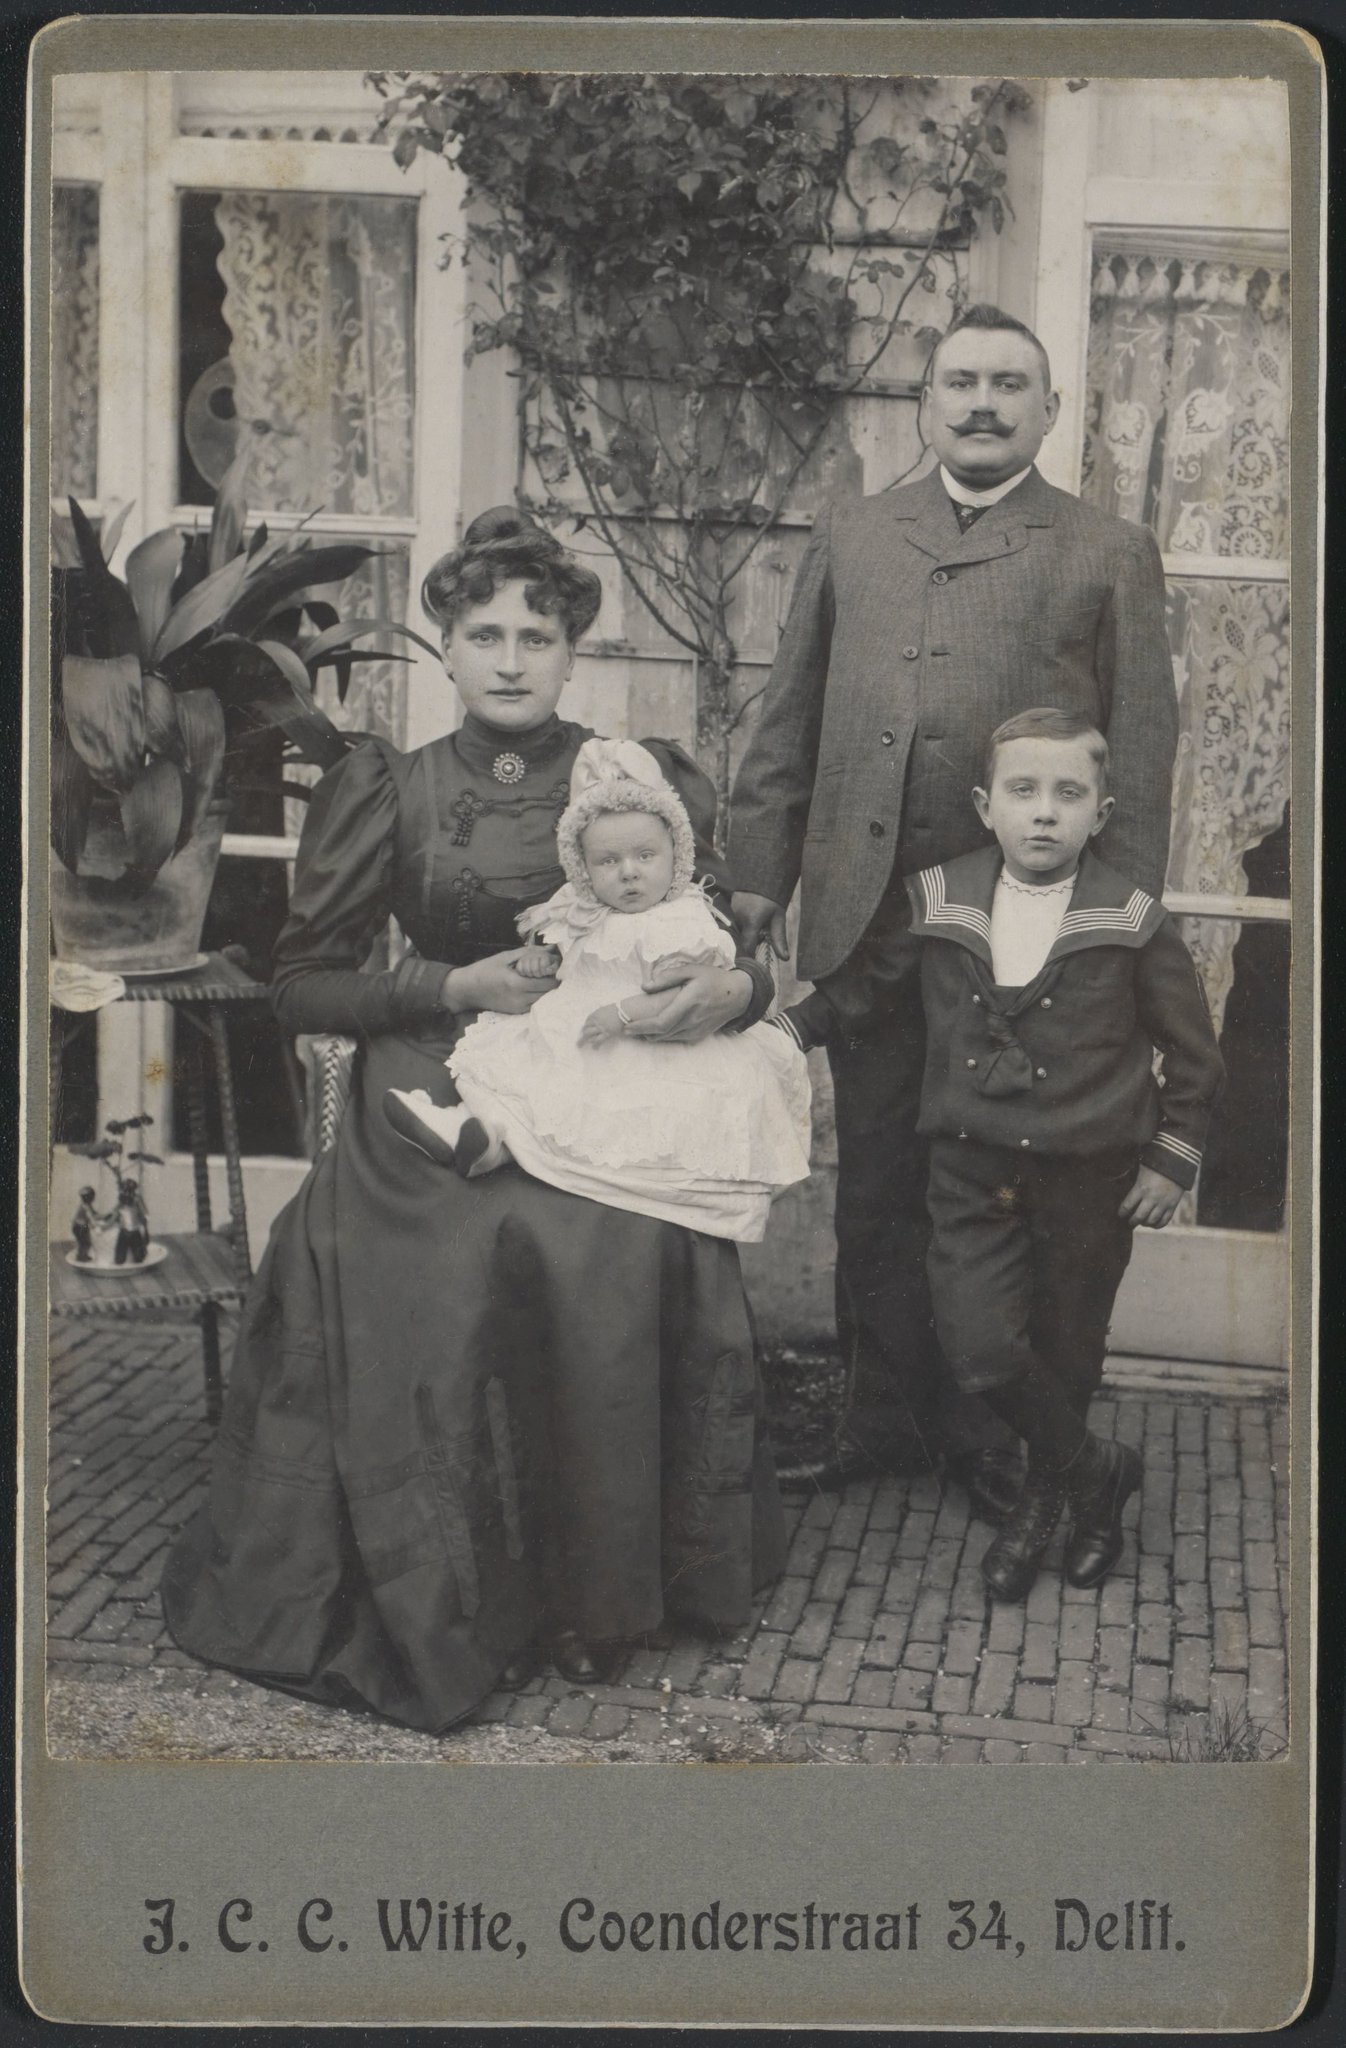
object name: photograph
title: Portret van een gezin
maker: johannes christiaan coenraad witte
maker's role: fotograaf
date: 1895-1905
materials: cardboard, photographic support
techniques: gelatin silver print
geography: delft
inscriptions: number: ‘6’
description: Een zittende vrouw met een baby op schoot, een staande jongen in een matrozenpak en een staande man. Zij poseren buiten, voor een gevel met ramen en een rozenstruik. Naast de vrouw een tafeltje met een plant er op.